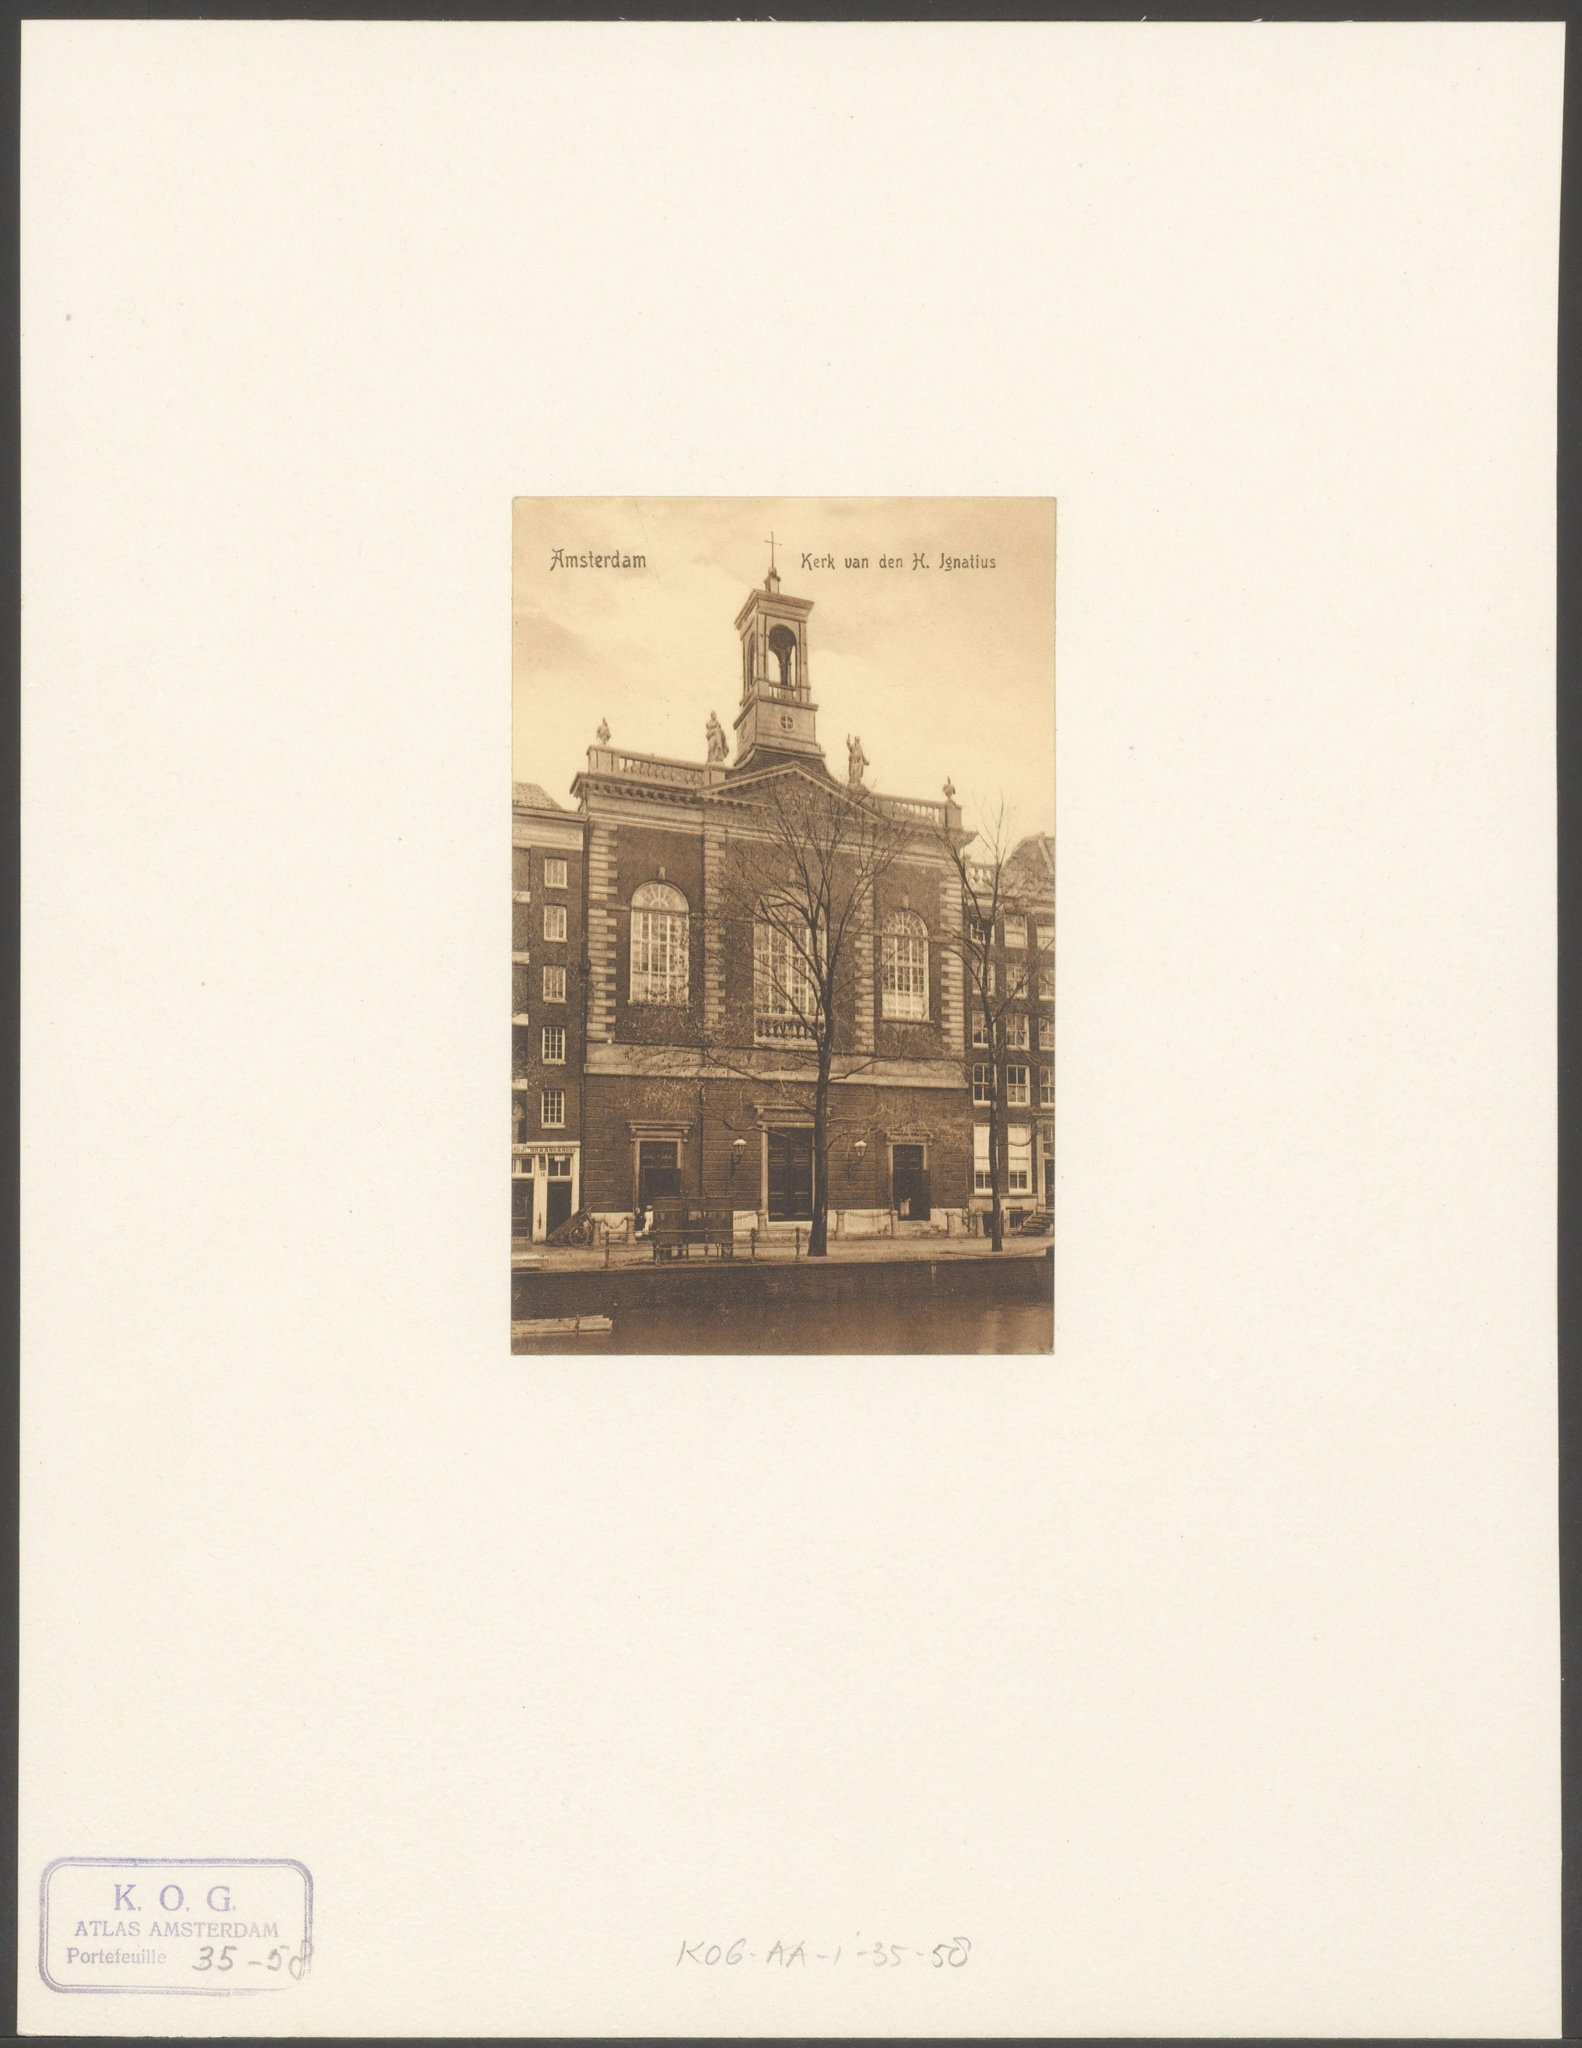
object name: photomechanical print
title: Amsterdam Kerk van den H. Ignatius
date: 1910-1912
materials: cardboard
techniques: photograph, letterpress printing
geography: amsterdam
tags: roman catholic church, canals, waters (in city), parts of church exterior and annexes: façade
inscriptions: collector's mark: ‘35-58’ Lugt 1641b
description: Onderwerpsrubriek binnen de Atlas Amsterdam: R.K. Gemeenten: Sint Nicolaaskerk t/m Willibrordus (Rustenburgerstraat).